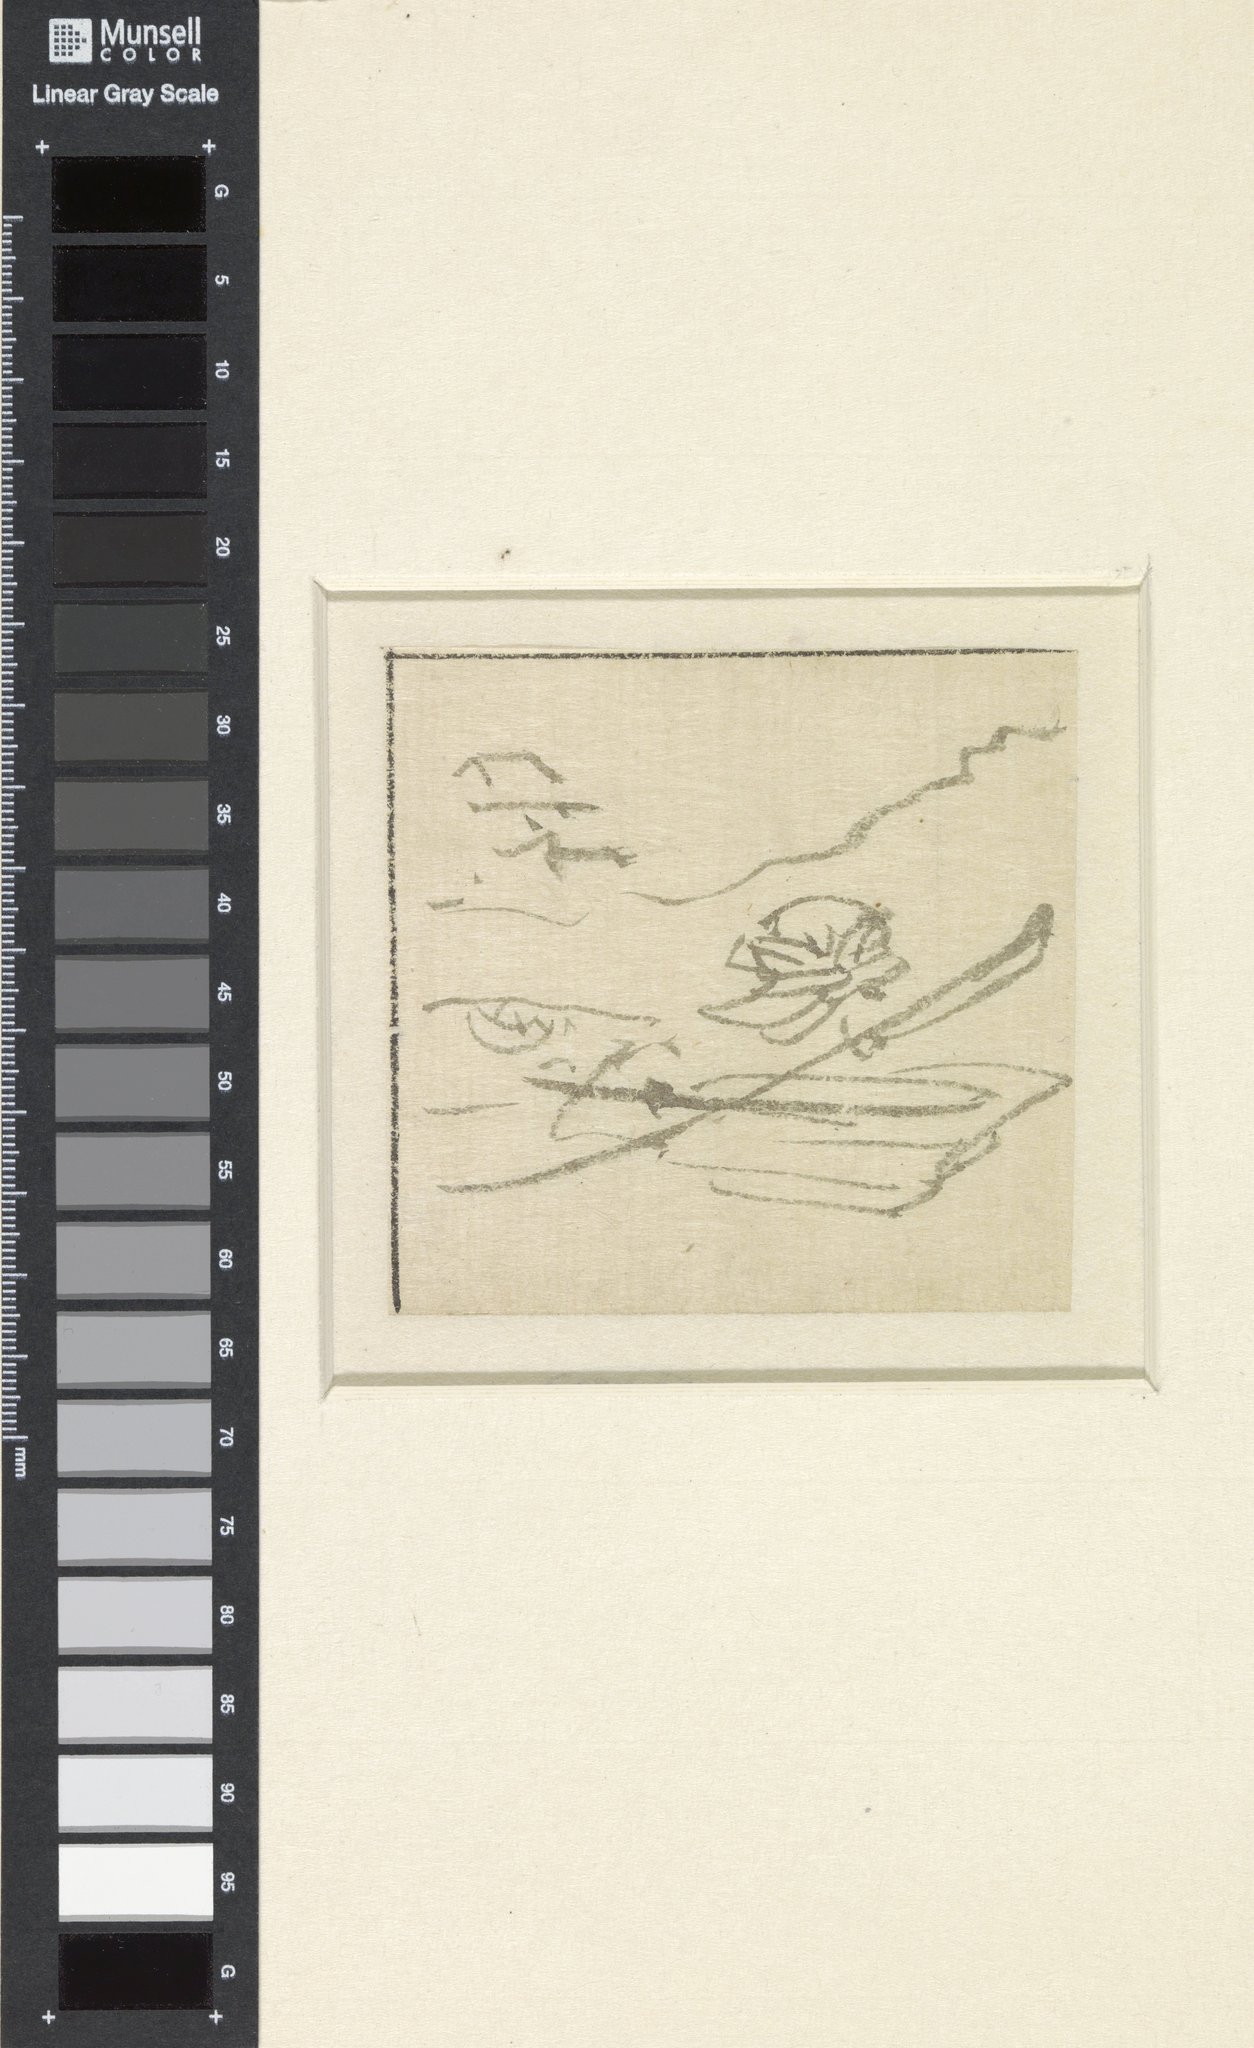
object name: drawing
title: Schetsblad met wapens en helm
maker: utagawa hiroshige (i)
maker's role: draughtsman, print maker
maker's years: 1797-1858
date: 1807-1858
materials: paper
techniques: brush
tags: rowing-boat, canoe, etc.